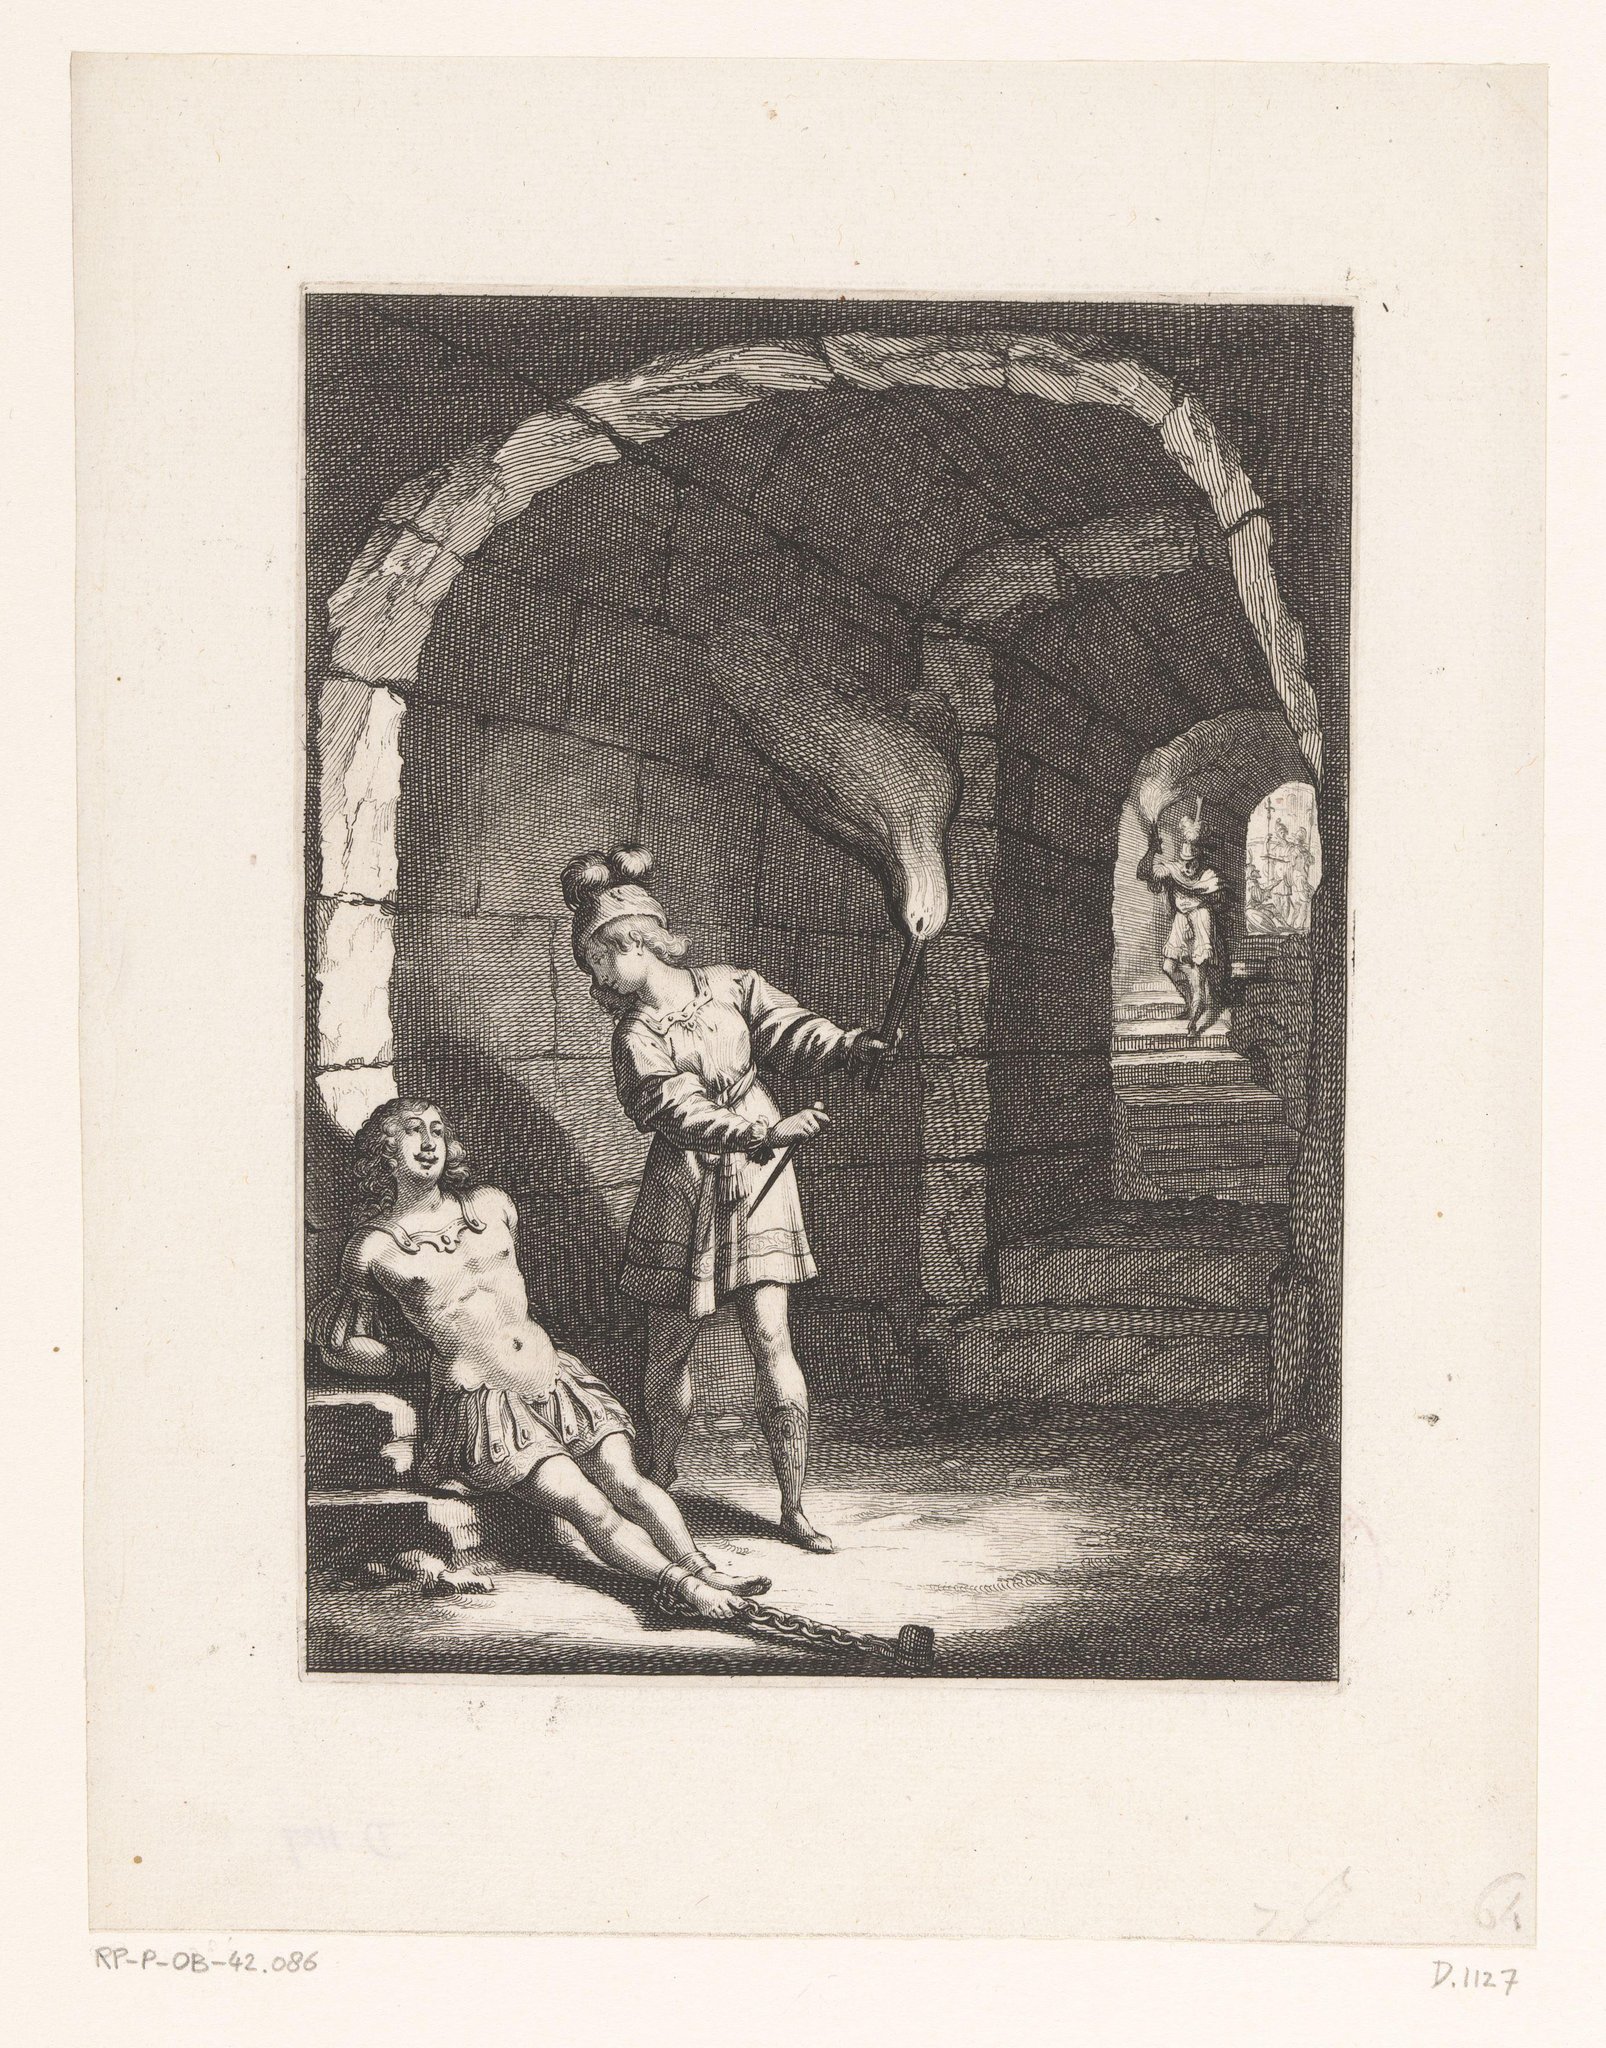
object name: book illustration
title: Dicargue bevrijdt Palamède uit de kerker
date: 1639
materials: paper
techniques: engraving, etching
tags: escape, escape attempts, prisoner; in fetters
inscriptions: collector's mark: Lugt 240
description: Prent uit: Desmarets de Saint-Sorlin, Jean. L'Ariane. Parijs: Guillemot, Matthieu, 1639.